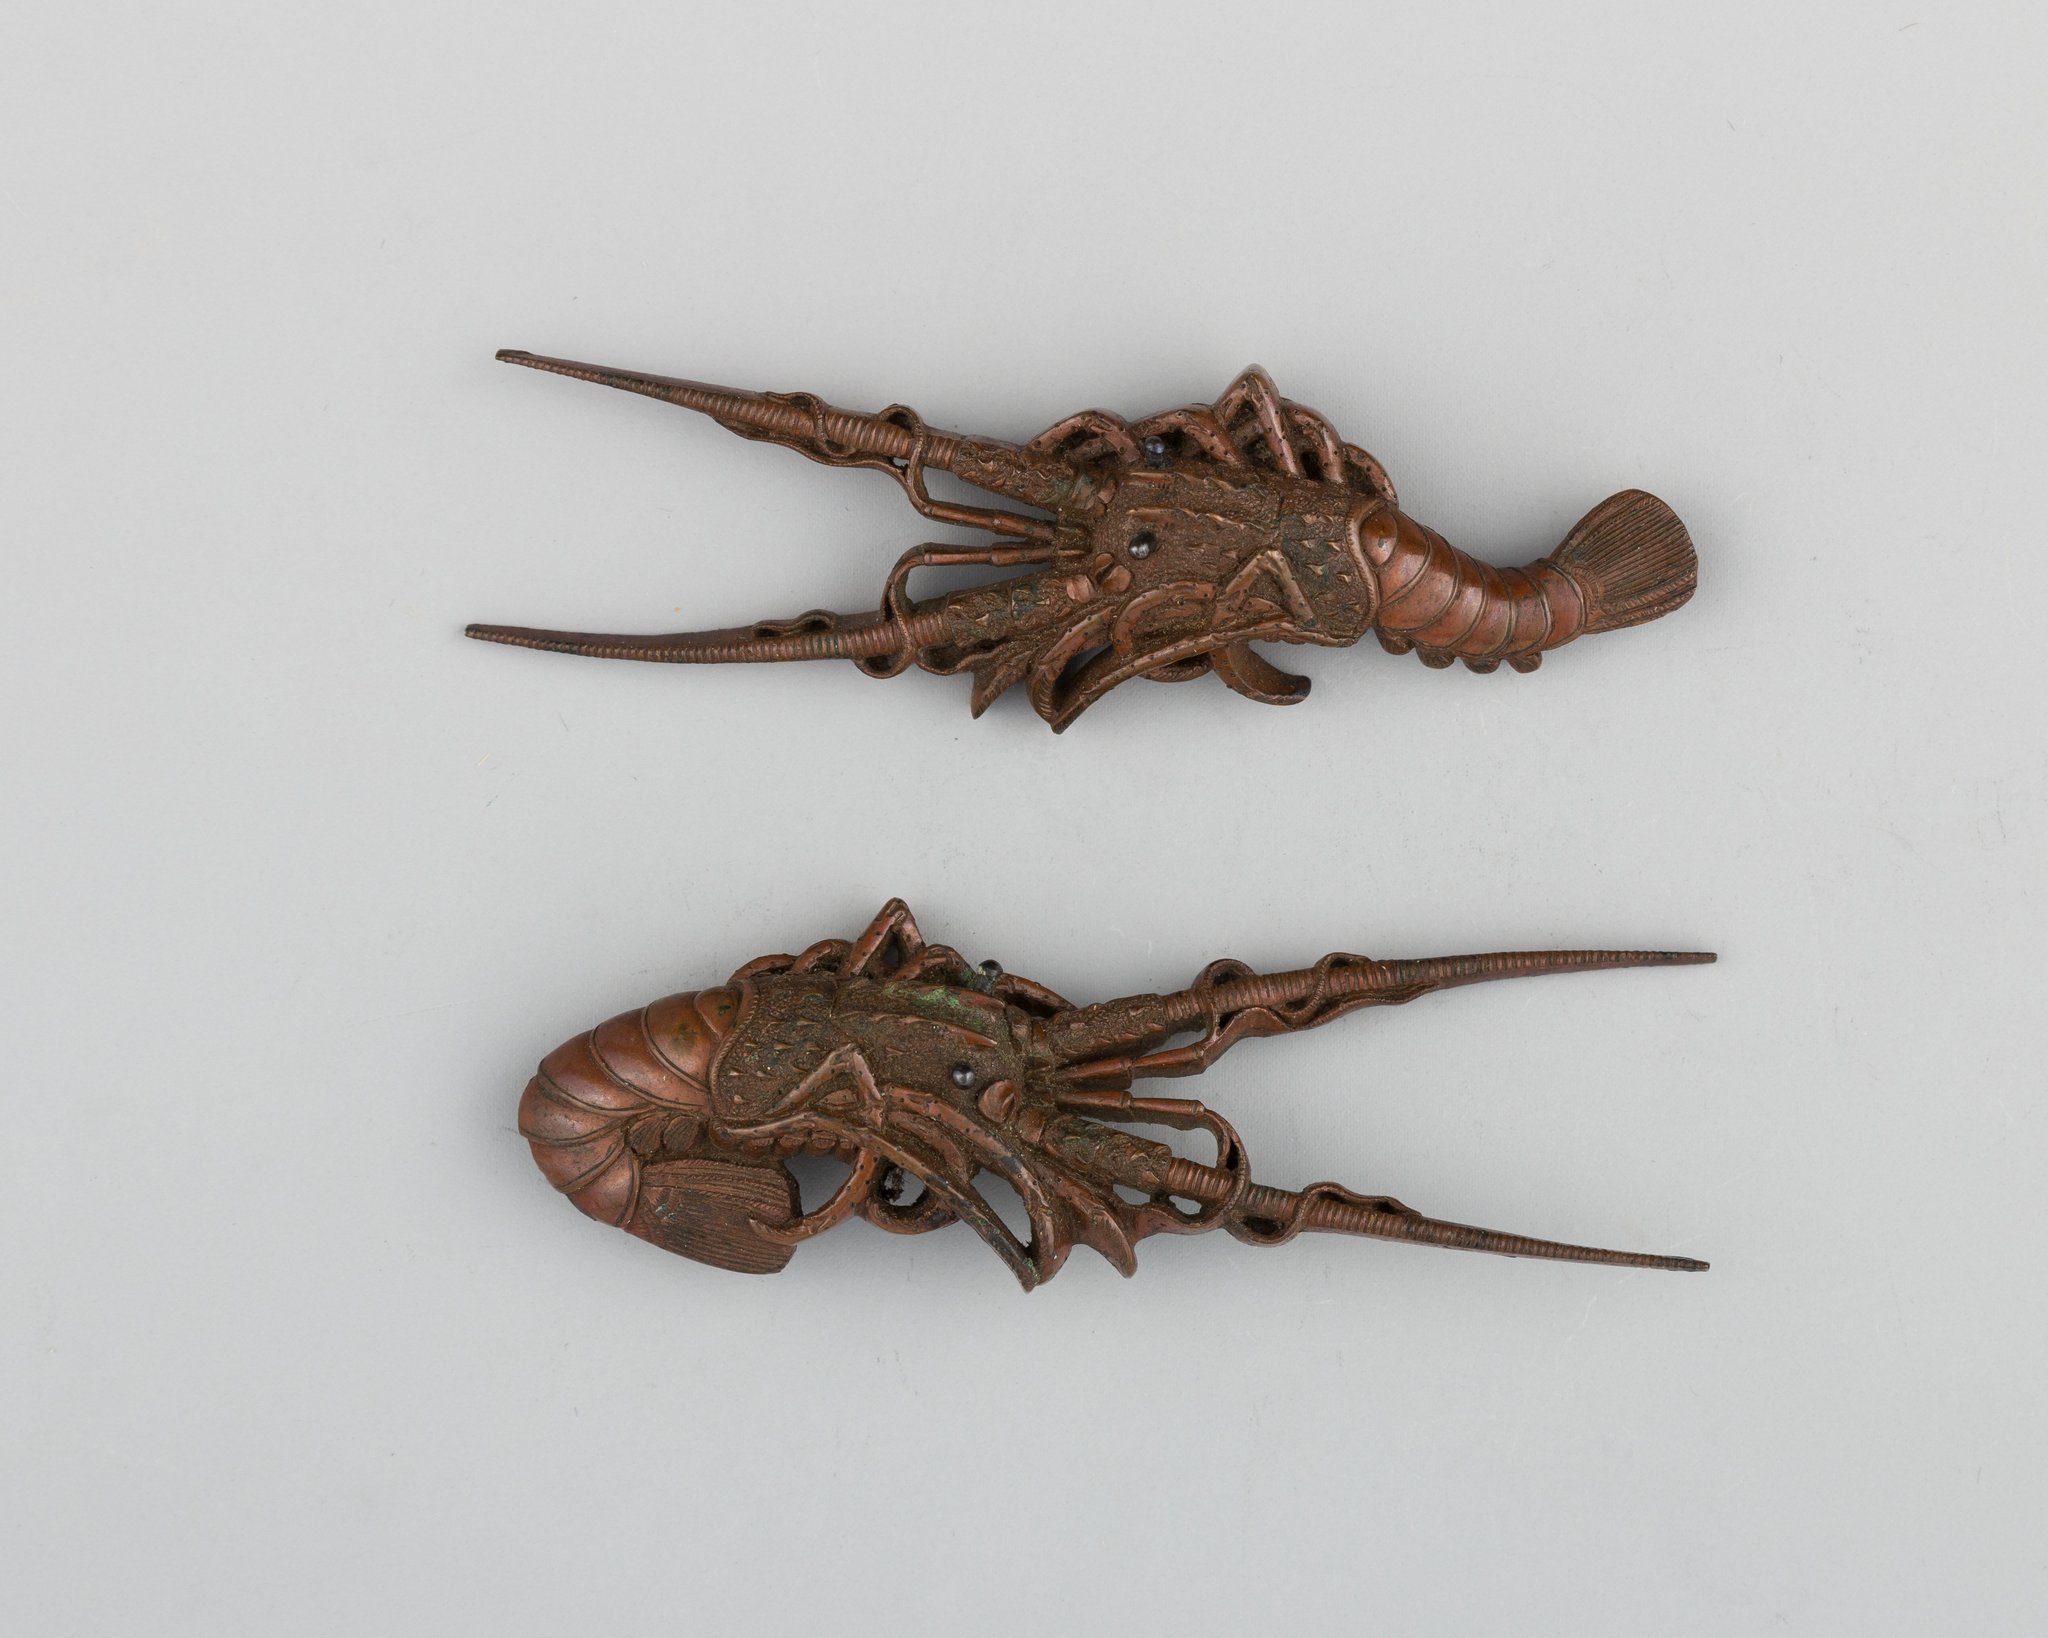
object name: pair of sword grip ornament menuki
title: Pair of Sword-Grip Ornaments (Menuki)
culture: japanese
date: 1701-1800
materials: copper, gold alloy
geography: japan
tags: lobsters